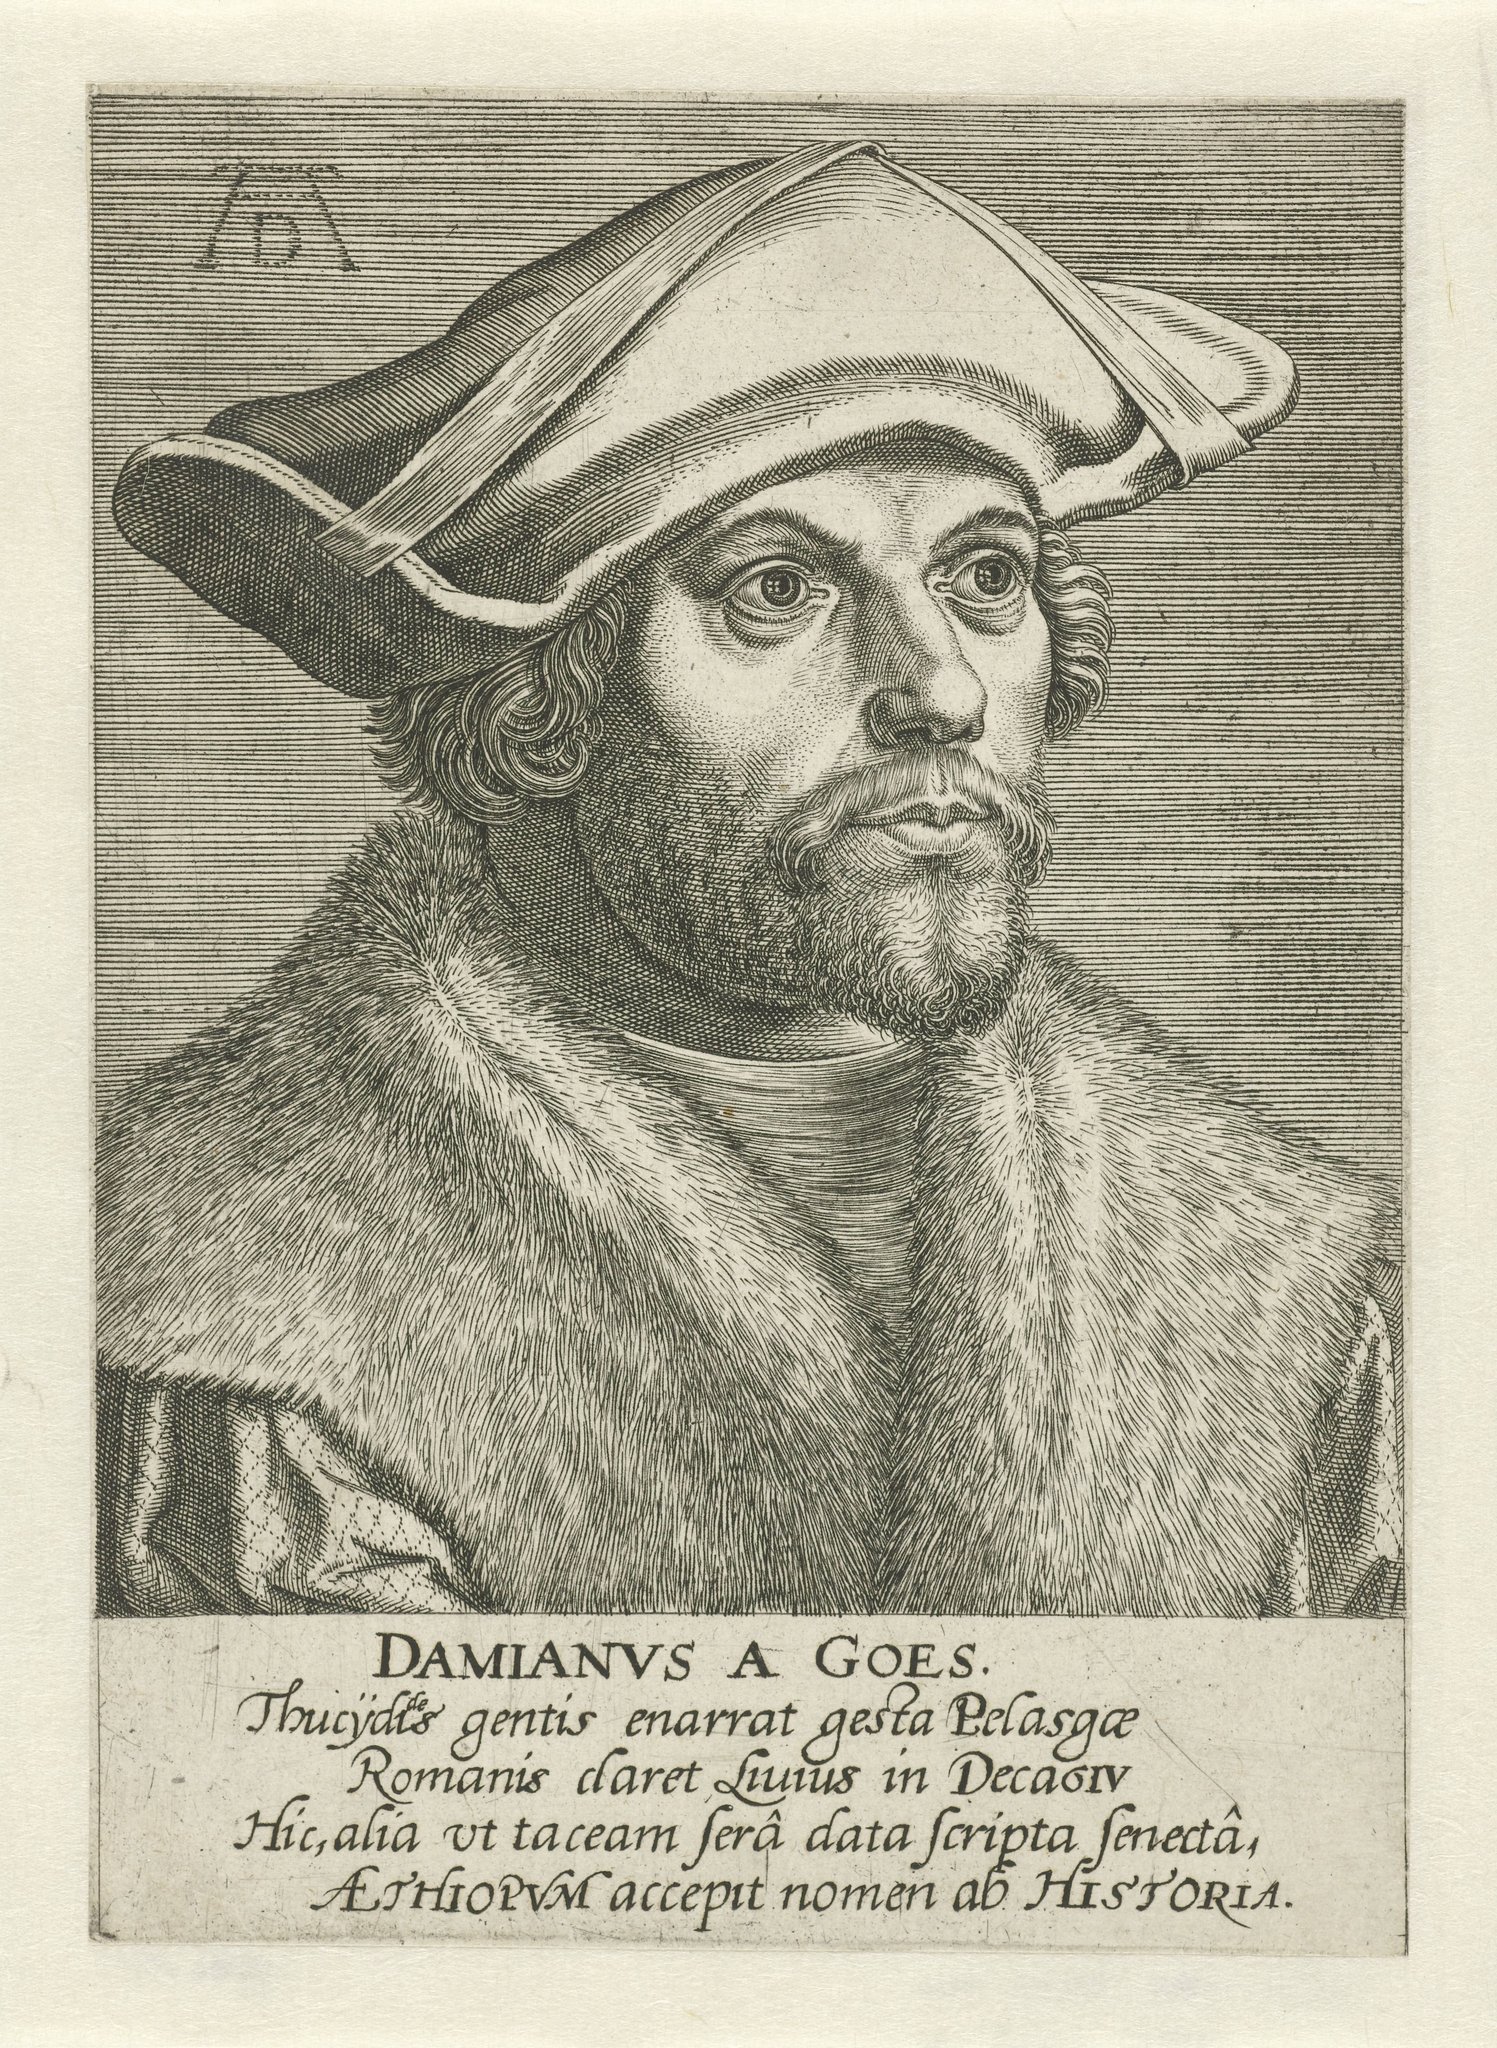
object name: print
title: Portret van Damiao de Gois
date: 1587-1612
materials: paper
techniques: engraving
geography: antwerp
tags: head-gear (bonnet) (+ men's clothes), historical persons, historical disciplines; philology (+ portrait of scholar, scientist)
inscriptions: collector's mark: Lugt 240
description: Portret van de Portugese humanist en historicus Damiao de Gois, vriend van Erasmus. Buste naar rechts. Met bonnet op hoofd, gekleed in mantel met bont.